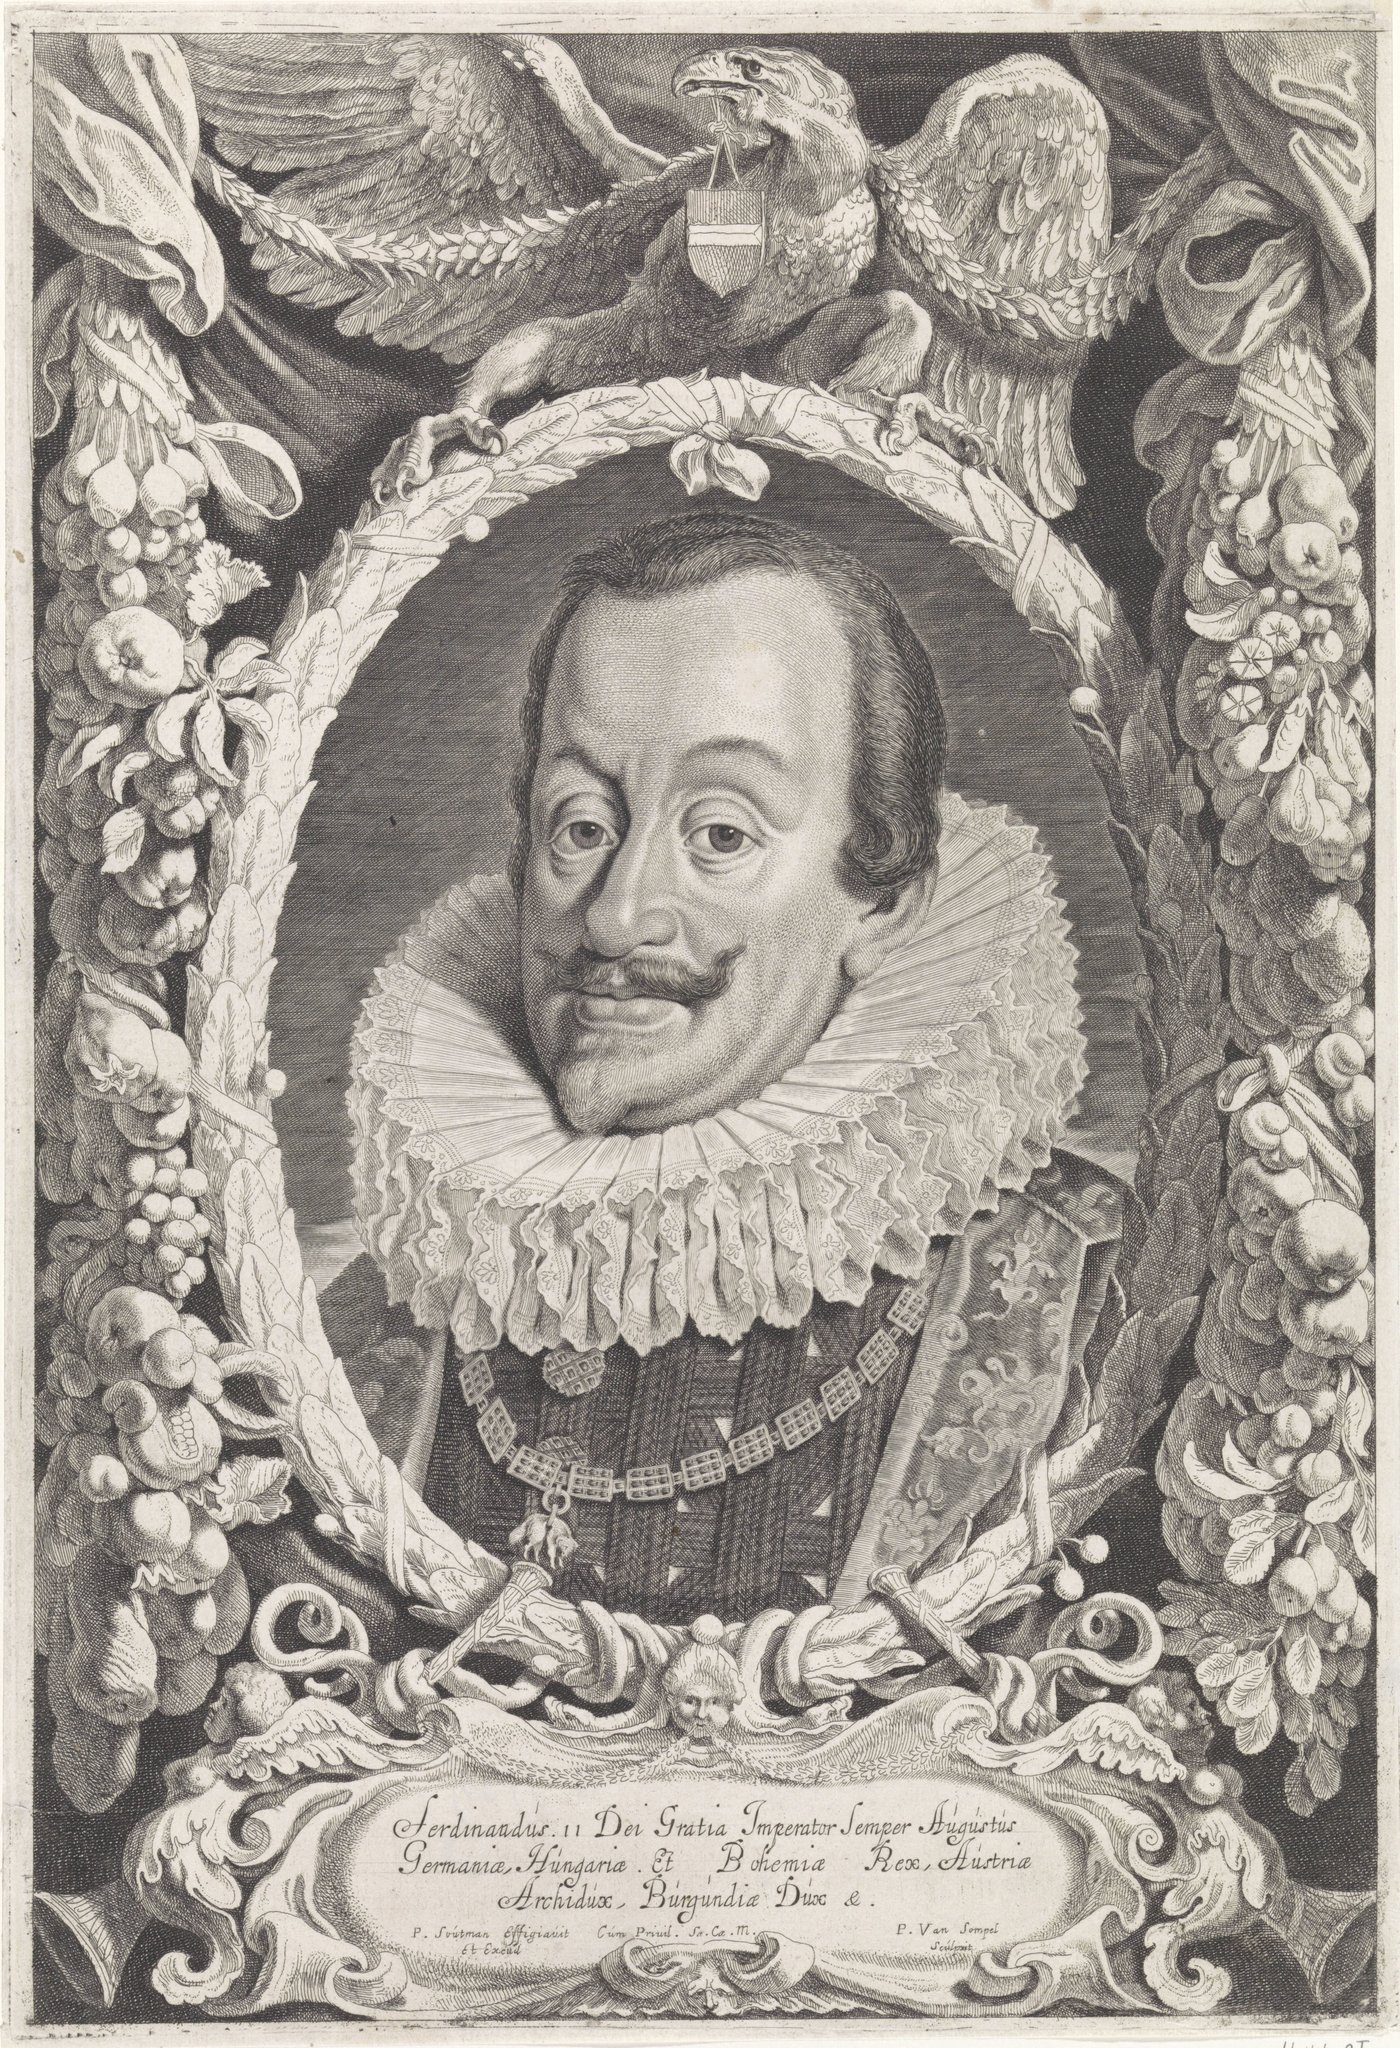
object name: print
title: Ferdinandus II[us] et III[us] Imperatorum Domus Austriacae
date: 1644-1650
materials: paper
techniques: engraving, etching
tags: vienna, ferdinand ii (duits keizer), knighthood order of the golden fleece - insignia of a knighthood order, e.g.: badge, chain (with name of order)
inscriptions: collector's mark: Lugt 2228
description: Portret van de Duitse keizer Ferdinand II. Om zijn hals draagt hij een keten met de versierselen van de Orde van het Gulden Vlies. Het portret wordt omlijst door guirlandes met vruchten. Bovenaan de Duitse adelaar die het wapenschild van de keizer in zijn bek houdt. Onder het portret een cartouche met in het Latijn zijn naam en titels.